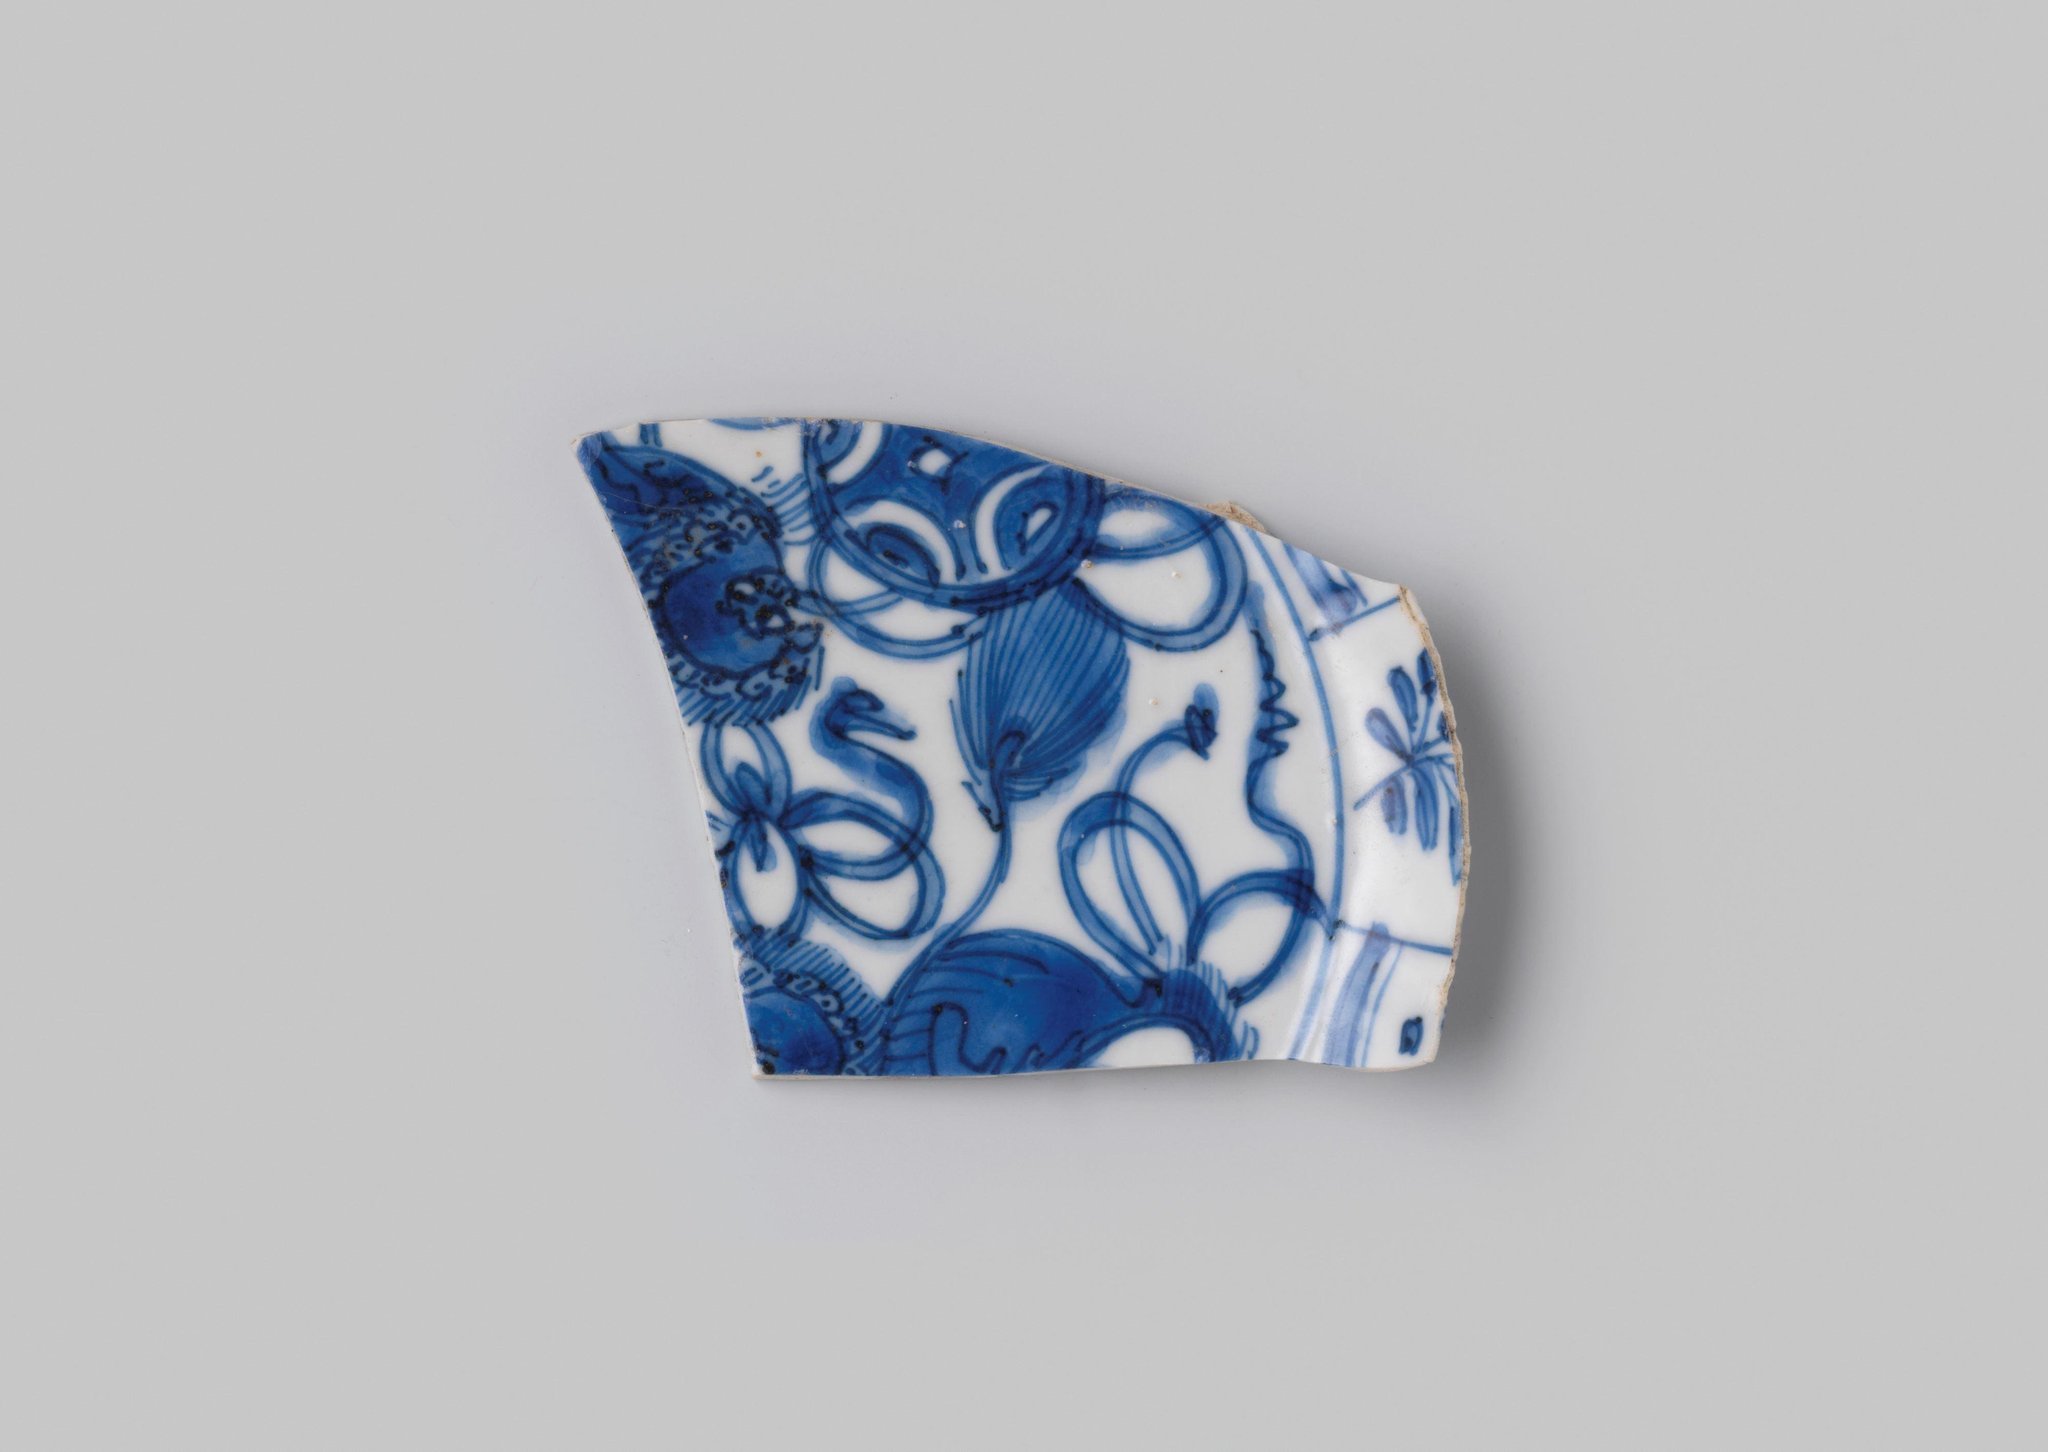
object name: plate dish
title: Fragment bord uit V.O.C.-schip de 'Witte Leeuw'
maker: Anonymous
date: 1613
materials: bone china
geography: jingdezhen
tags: verenigde oostindische compagnie, sint-helena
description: A saucer with a flattened rim. A saucer with a flattened rim. A central decoration of two lions playing with a ball. Panels decorated with peaches and flowers.